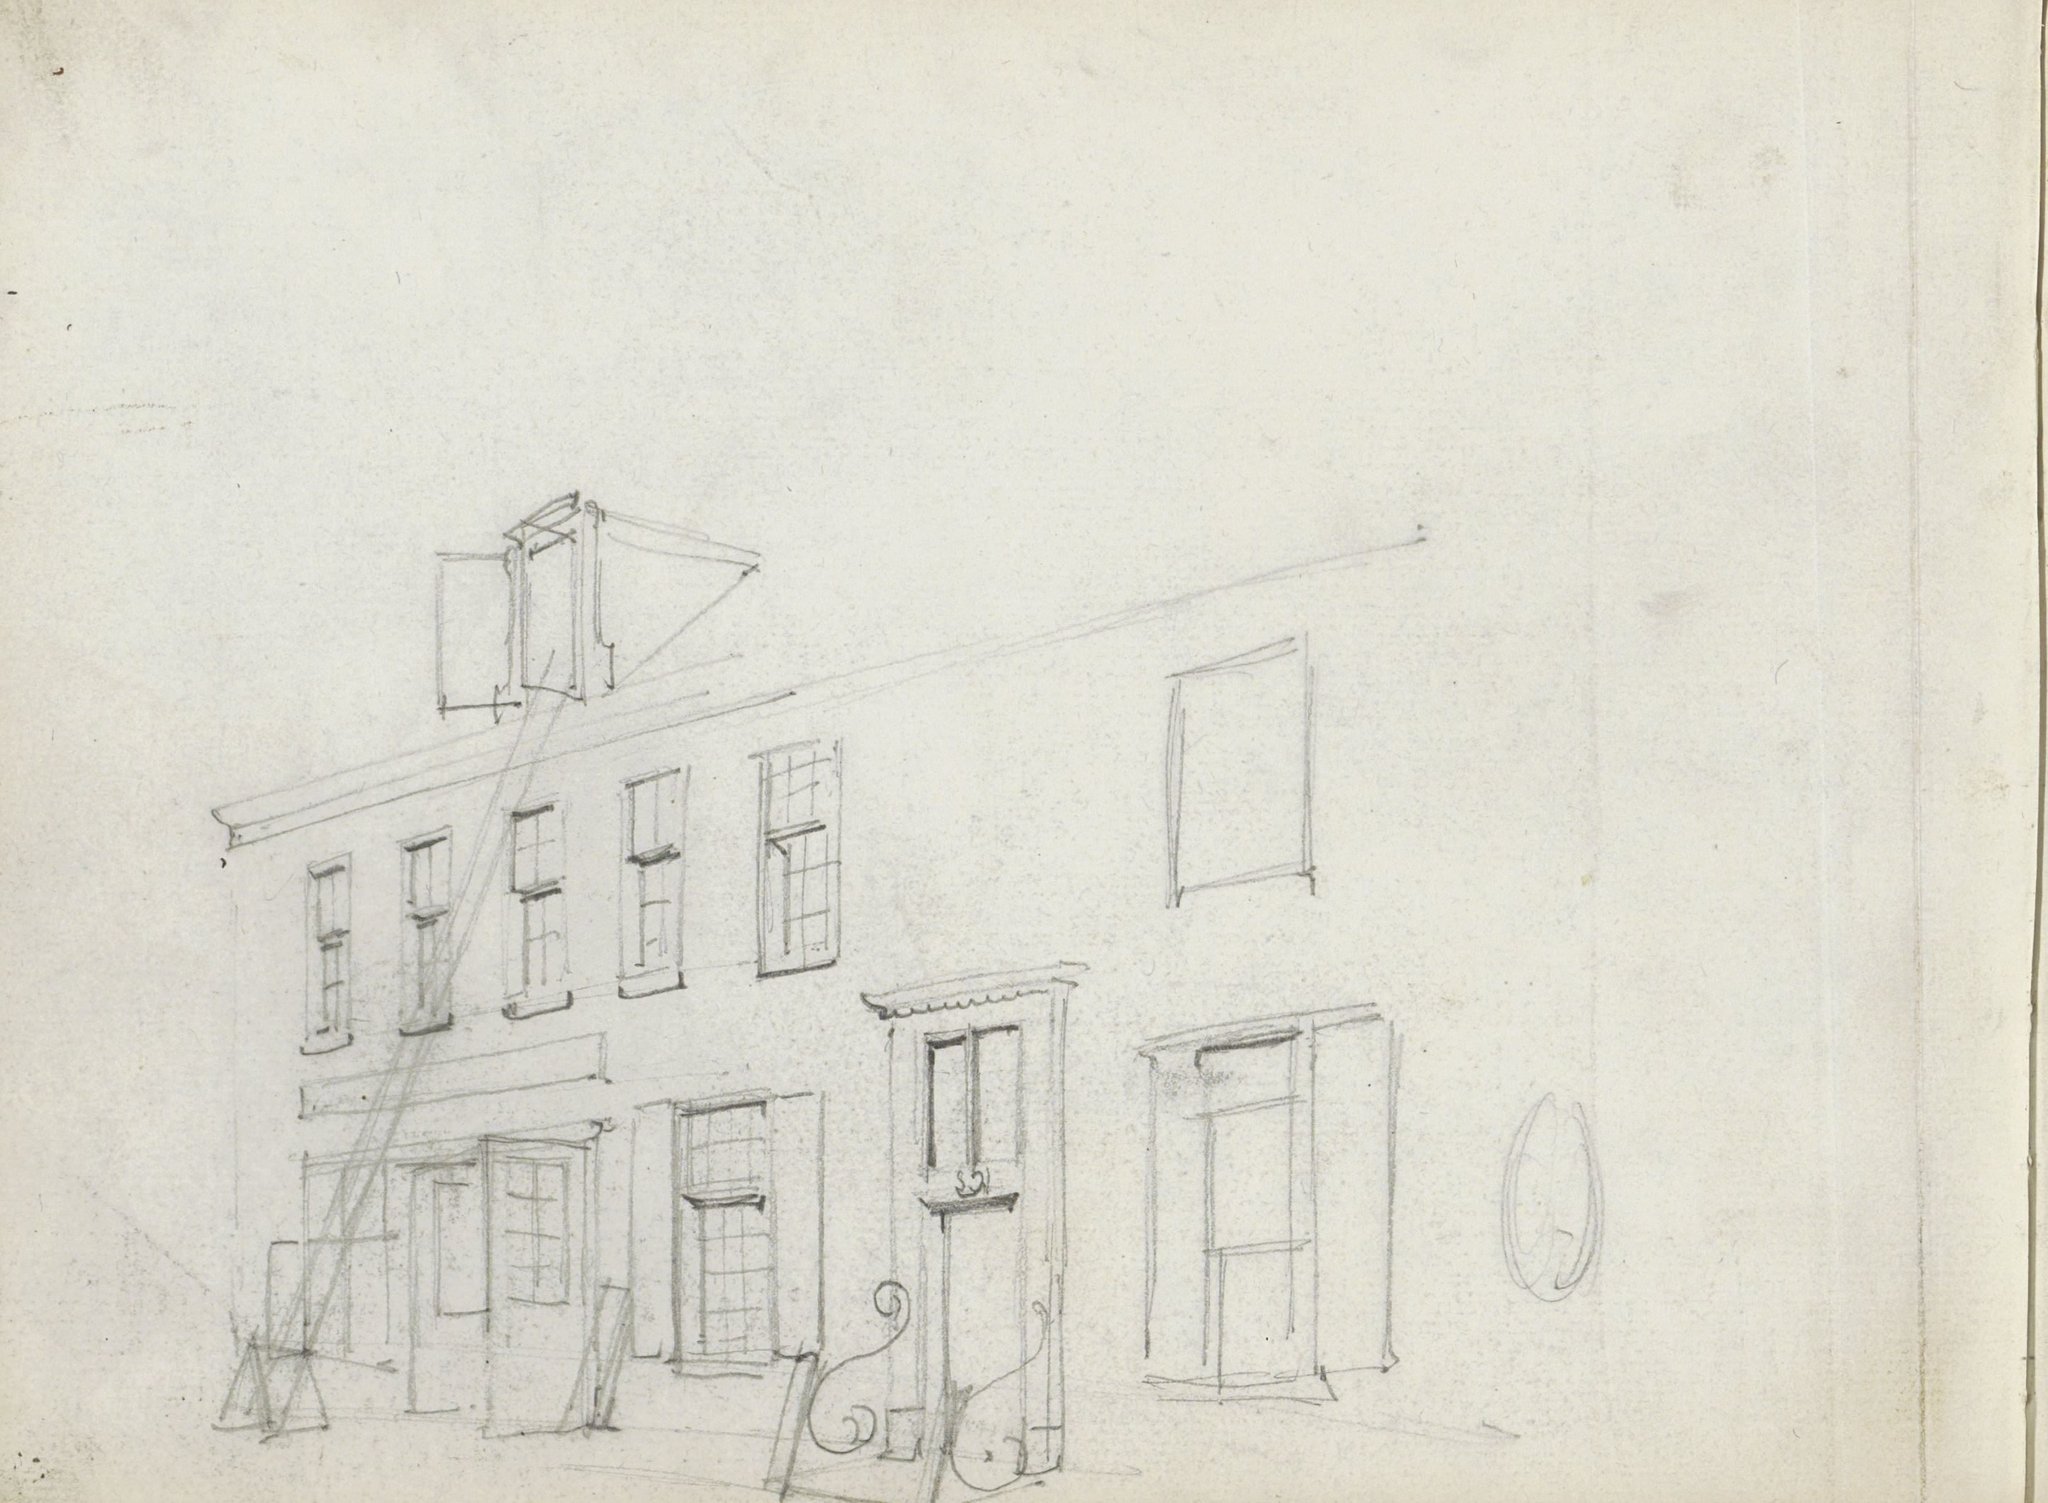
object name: sketchbook leaf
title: Gevel van een pand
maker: willem koekkoek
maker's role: draughtsman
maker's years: 1839-1895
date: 1849-1895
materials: paper, pencil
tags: façade (of house or building)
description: Pagina 15 verso uit een schetsboek met 26 bladen.